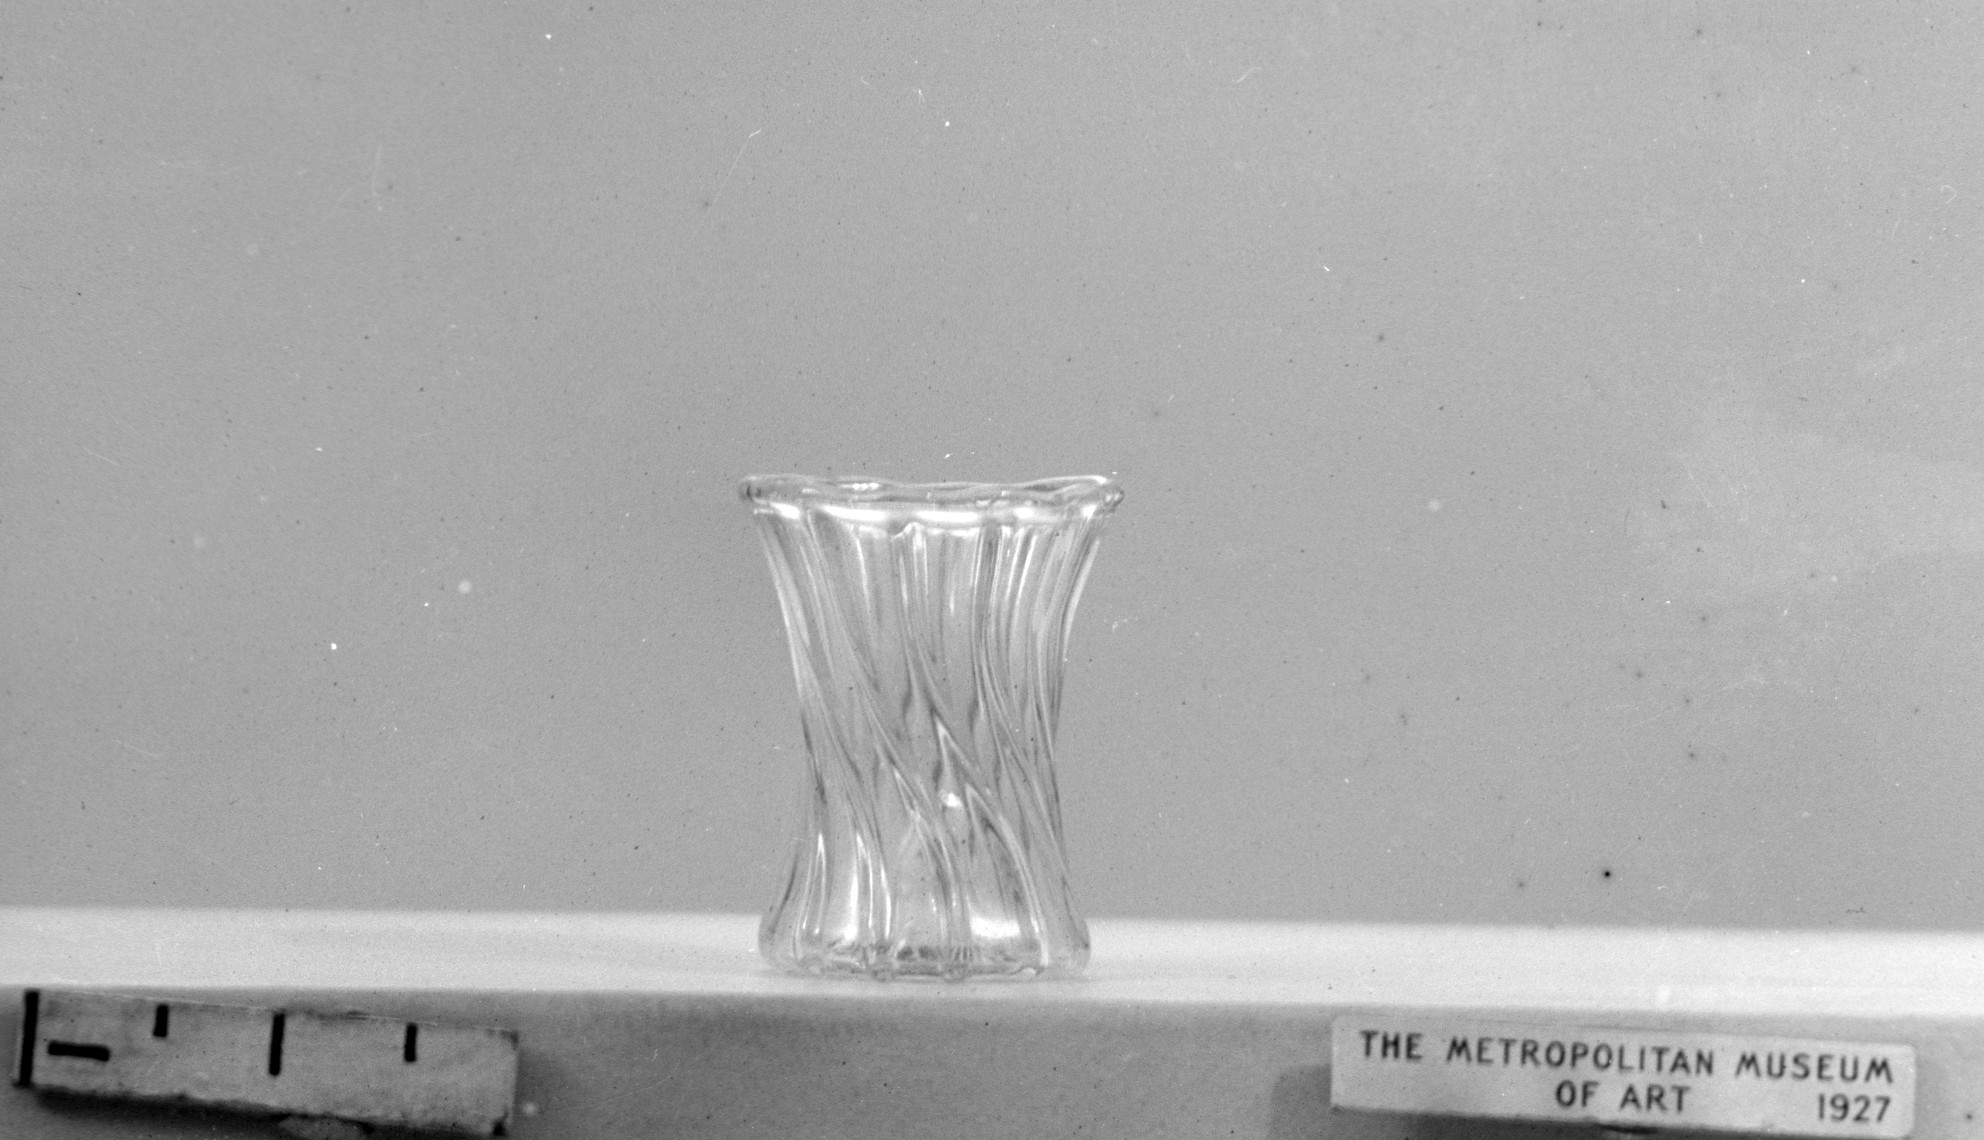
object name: beaker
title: Miniature beaker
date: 1801-1833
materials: glass